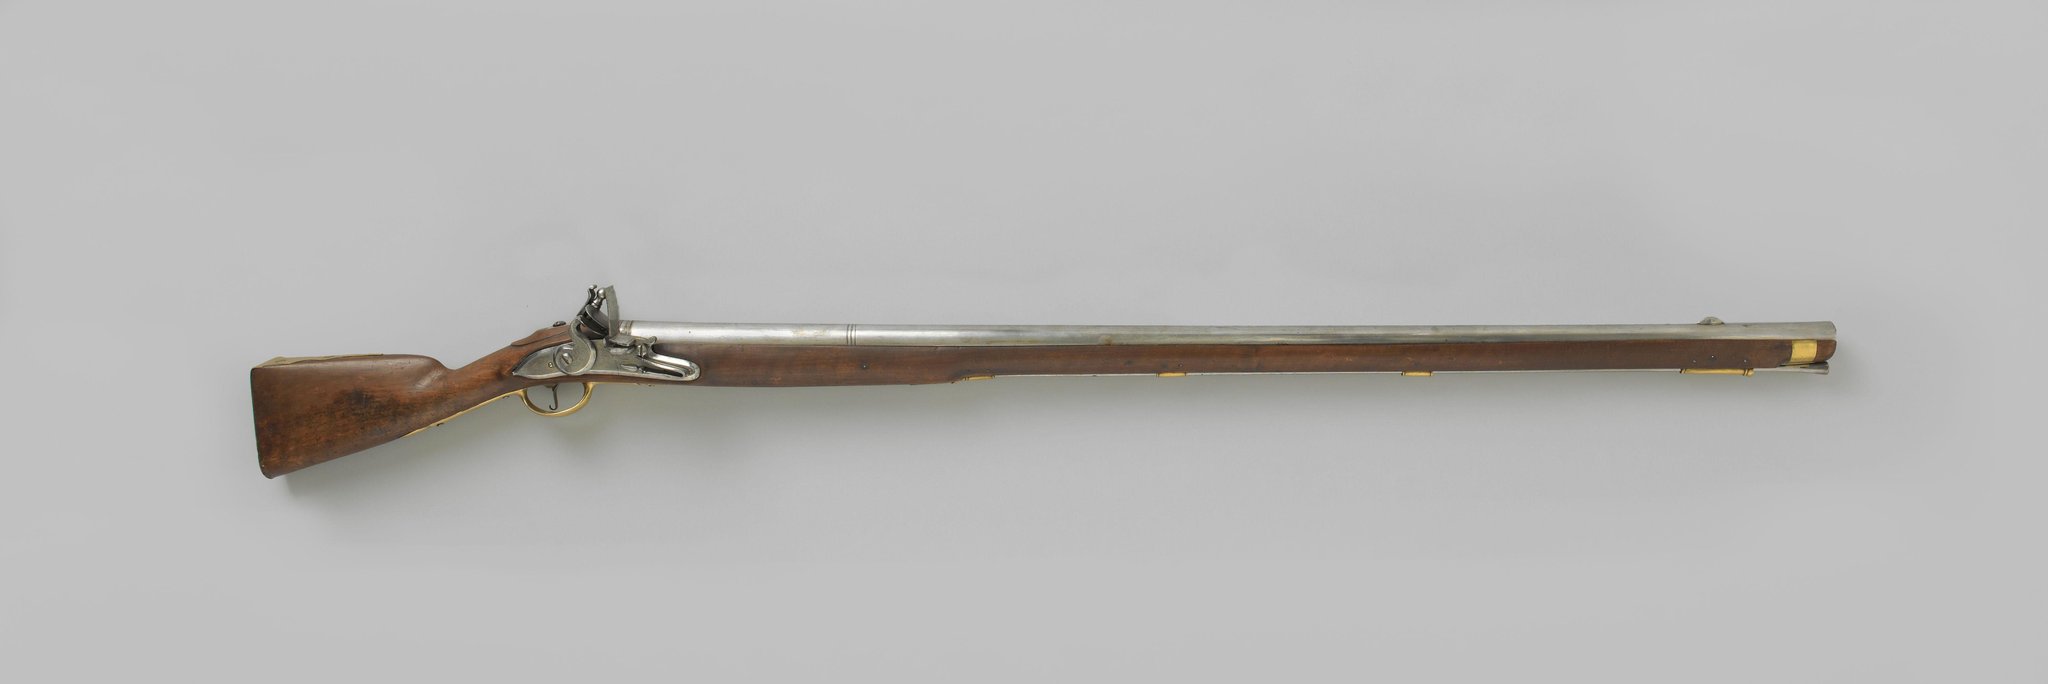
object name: musketoon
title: Flintlock Wall Piece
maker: Anonymous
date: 1825-1840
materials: brass, iron, wood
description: Vestinggeweer of vuursteen walbus, voorlader. De loop wordt niet met beugels aan de lade vastgehouden, maar heeft een klein oog onderop, waar doorheen pennen gestoken worden, die tevens dwars door de lade gaan. Het geweer heeft een ijzeren laadstok.